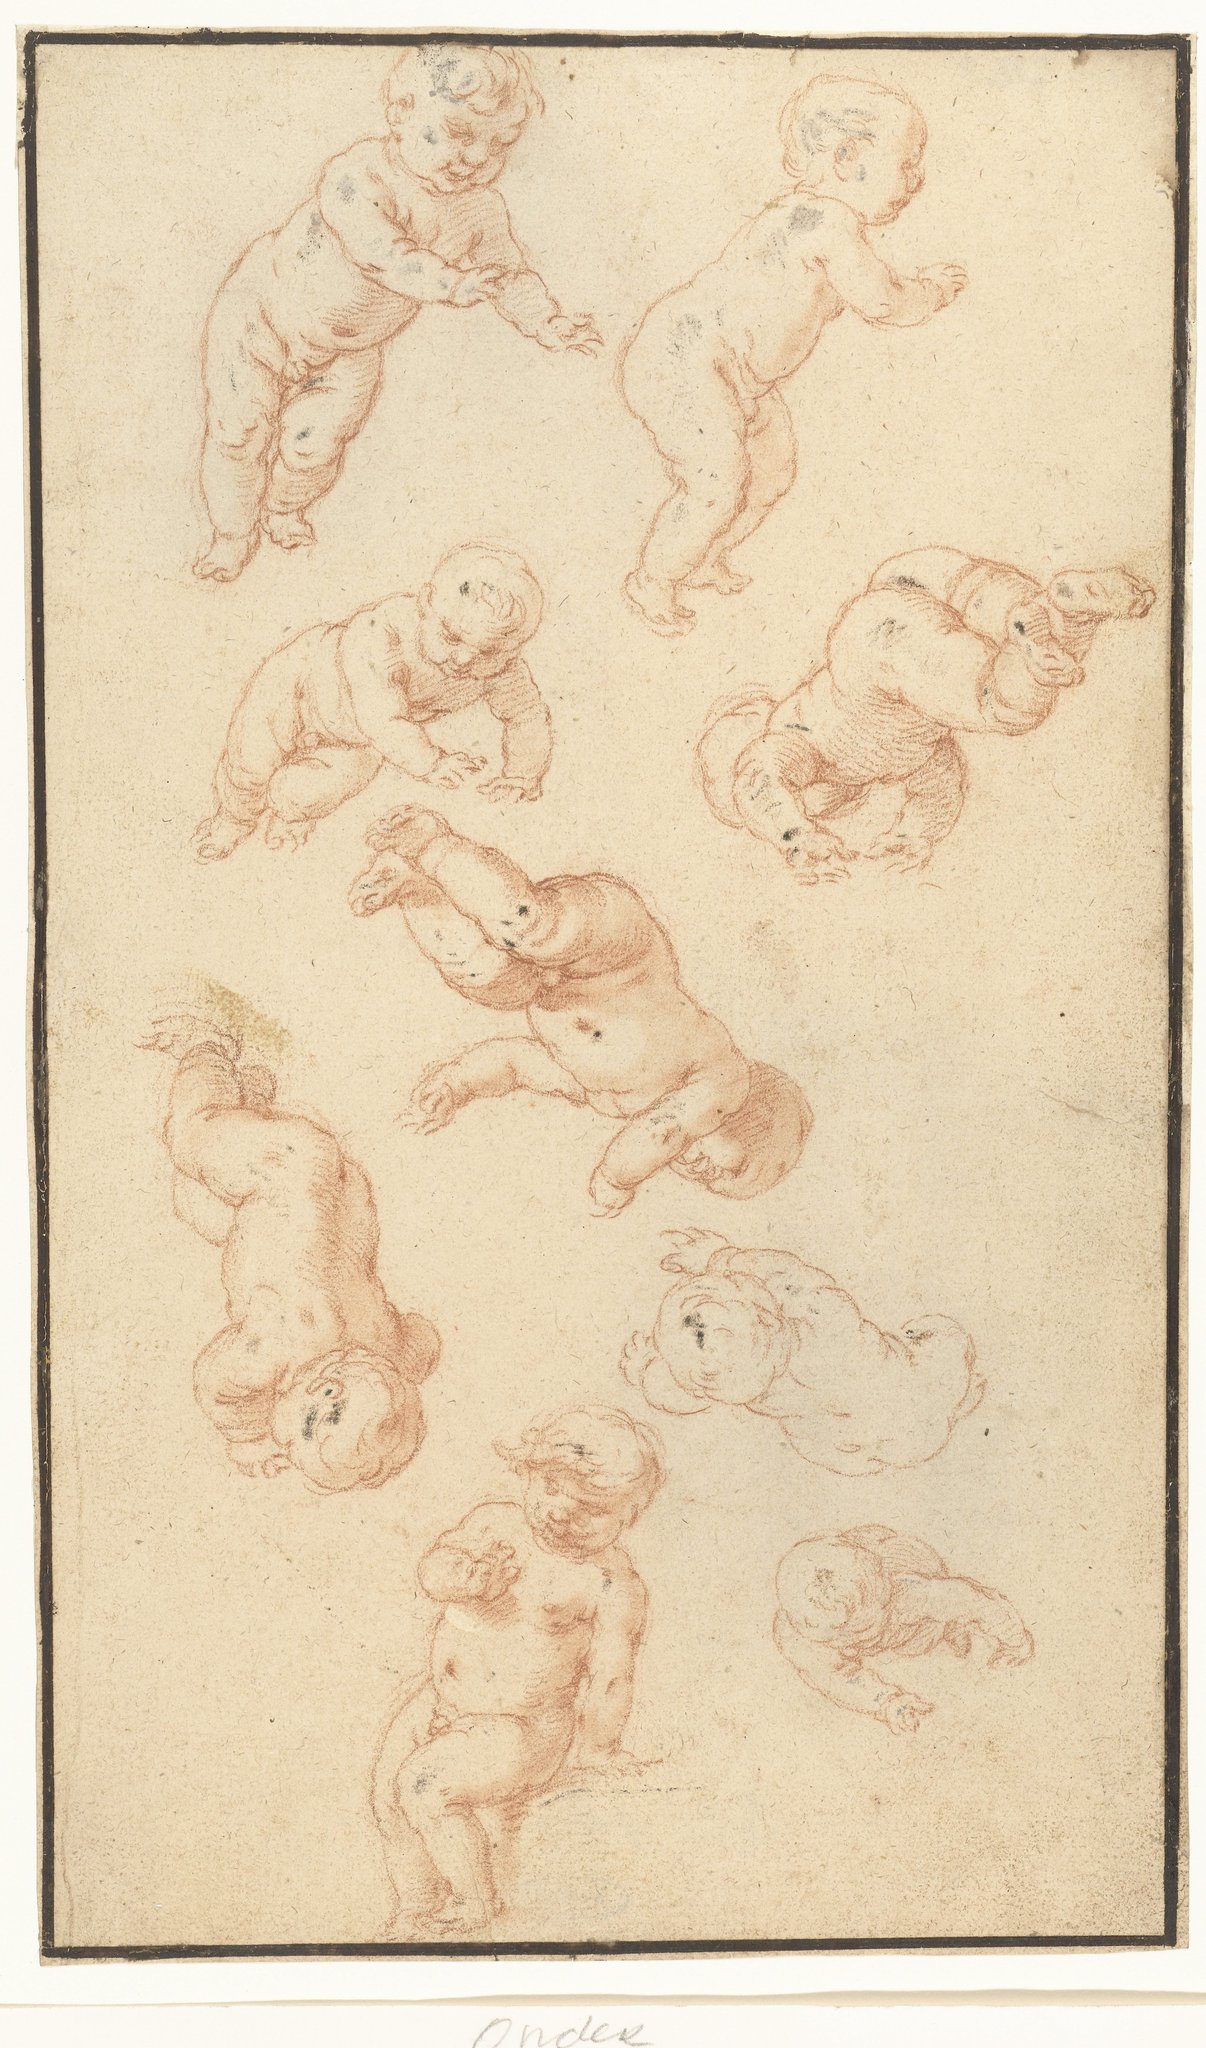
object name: drawing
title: Studieblad met negen putti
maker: abraham bloemaert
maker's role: draughtsman, painter, print maker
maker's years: 1566-1651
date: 1571-1651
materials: chalk, paint, paper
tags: infant, baby ~ the ages of man, cupids: 'amores', 'amoretti', 'putti'